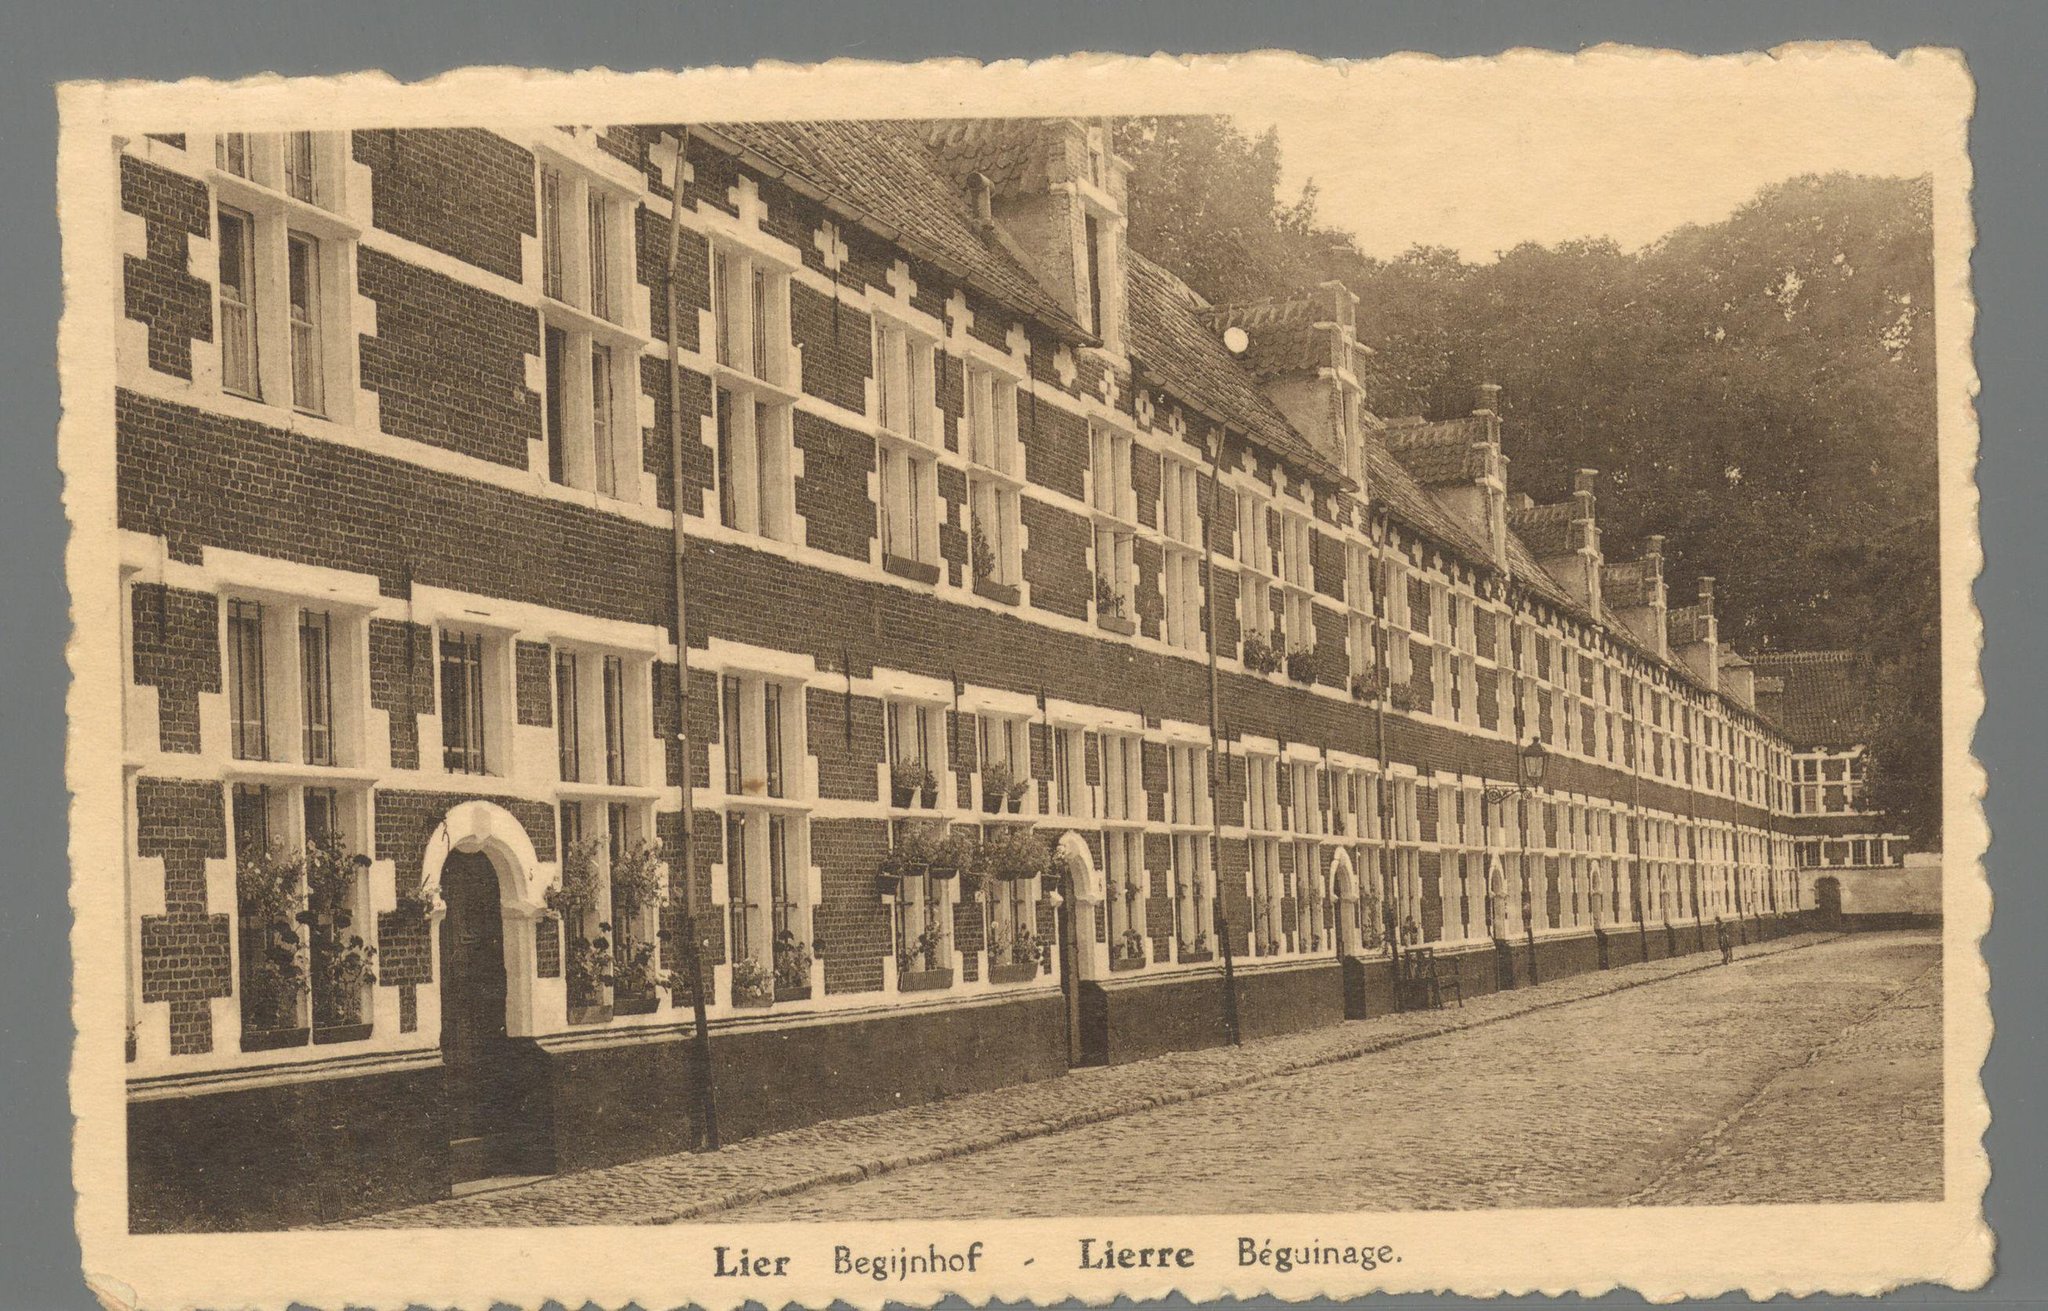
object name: ansichtkaart, prentbriefkaart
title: Lier. Begijnhof / Lierre. Béguinage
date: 1913-1950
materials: cardboard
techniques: photograph, writing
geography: brussels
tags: urban housing, old-people's home, lierre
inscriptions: poststempel, verso, gestempeld